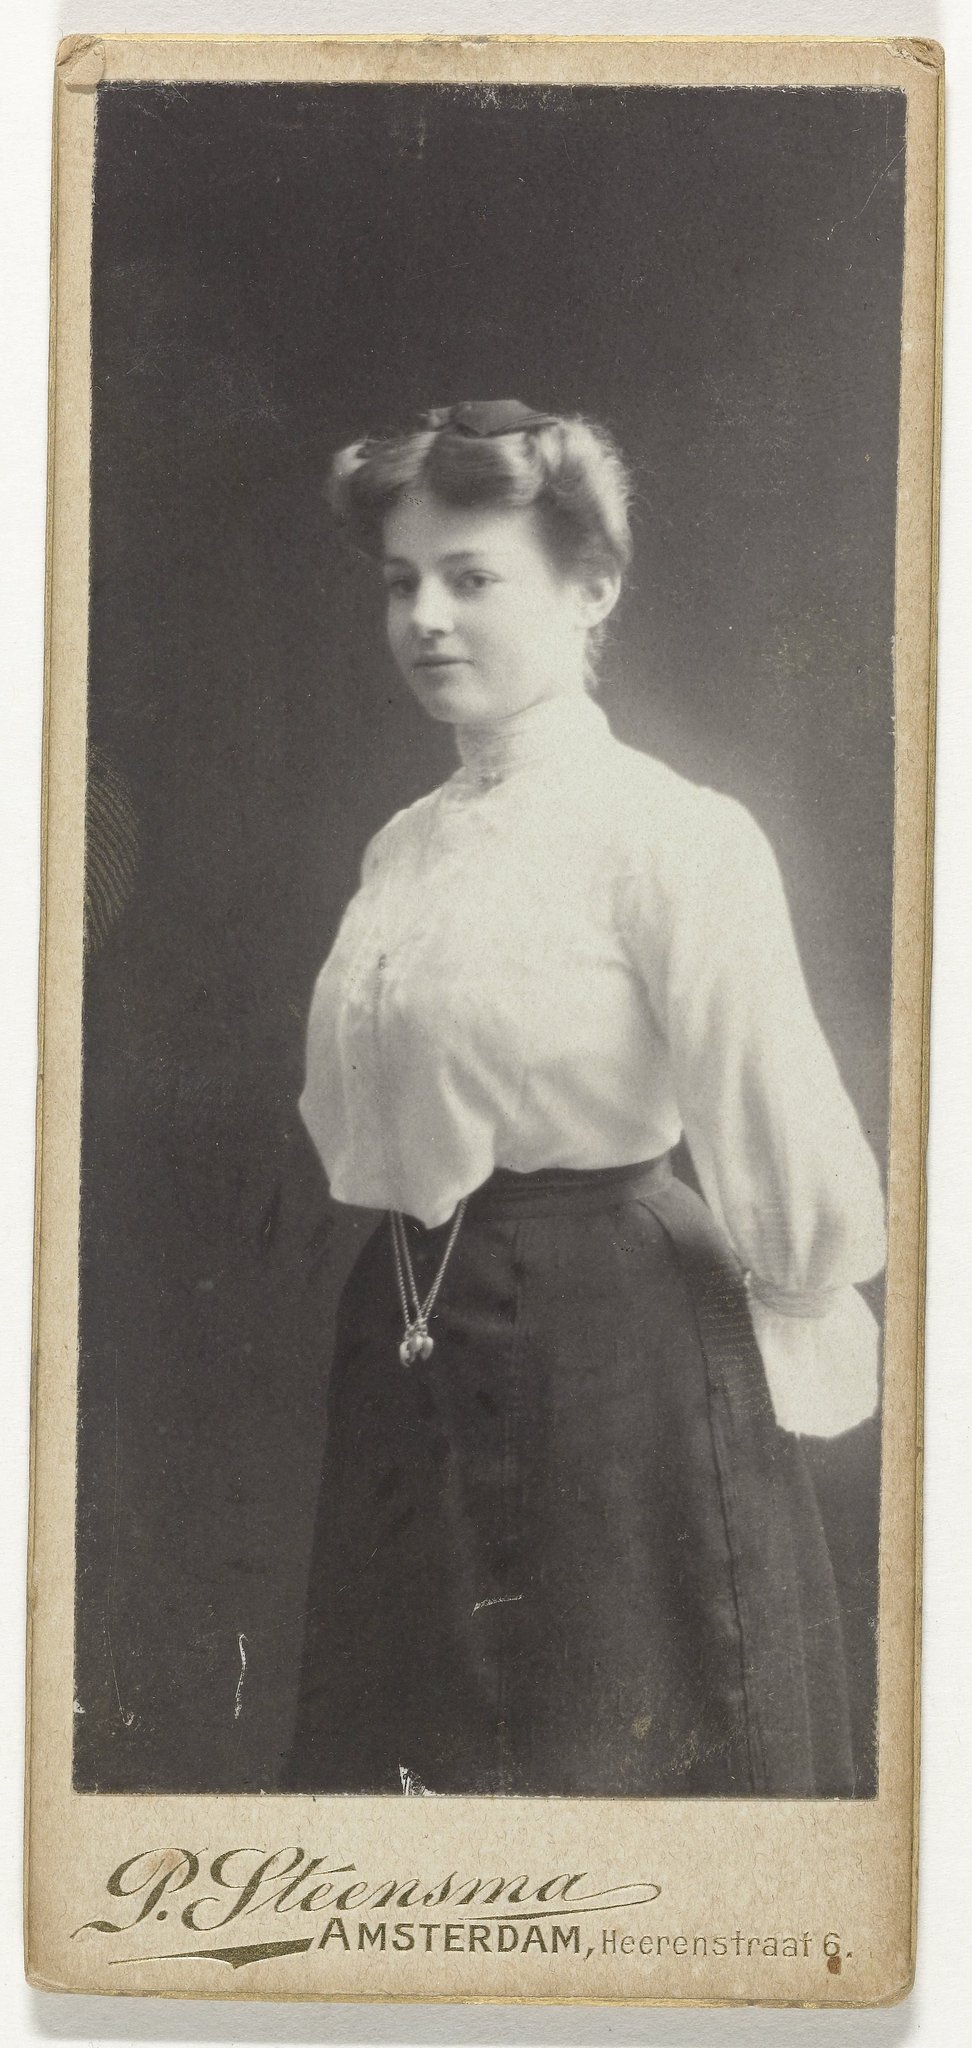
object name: carte de visite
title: Portret van een jonge vrouw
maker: pier steensma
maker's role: fotograaf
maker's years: 1879-1931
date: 1910-1920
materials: cardboard, paper, photographic support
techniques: albumen print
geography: amsterdam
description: Staande jonge vrouw, in een licht blouse en een donkere rok, met de handen op de rug, tegen een donkere achtergrond.